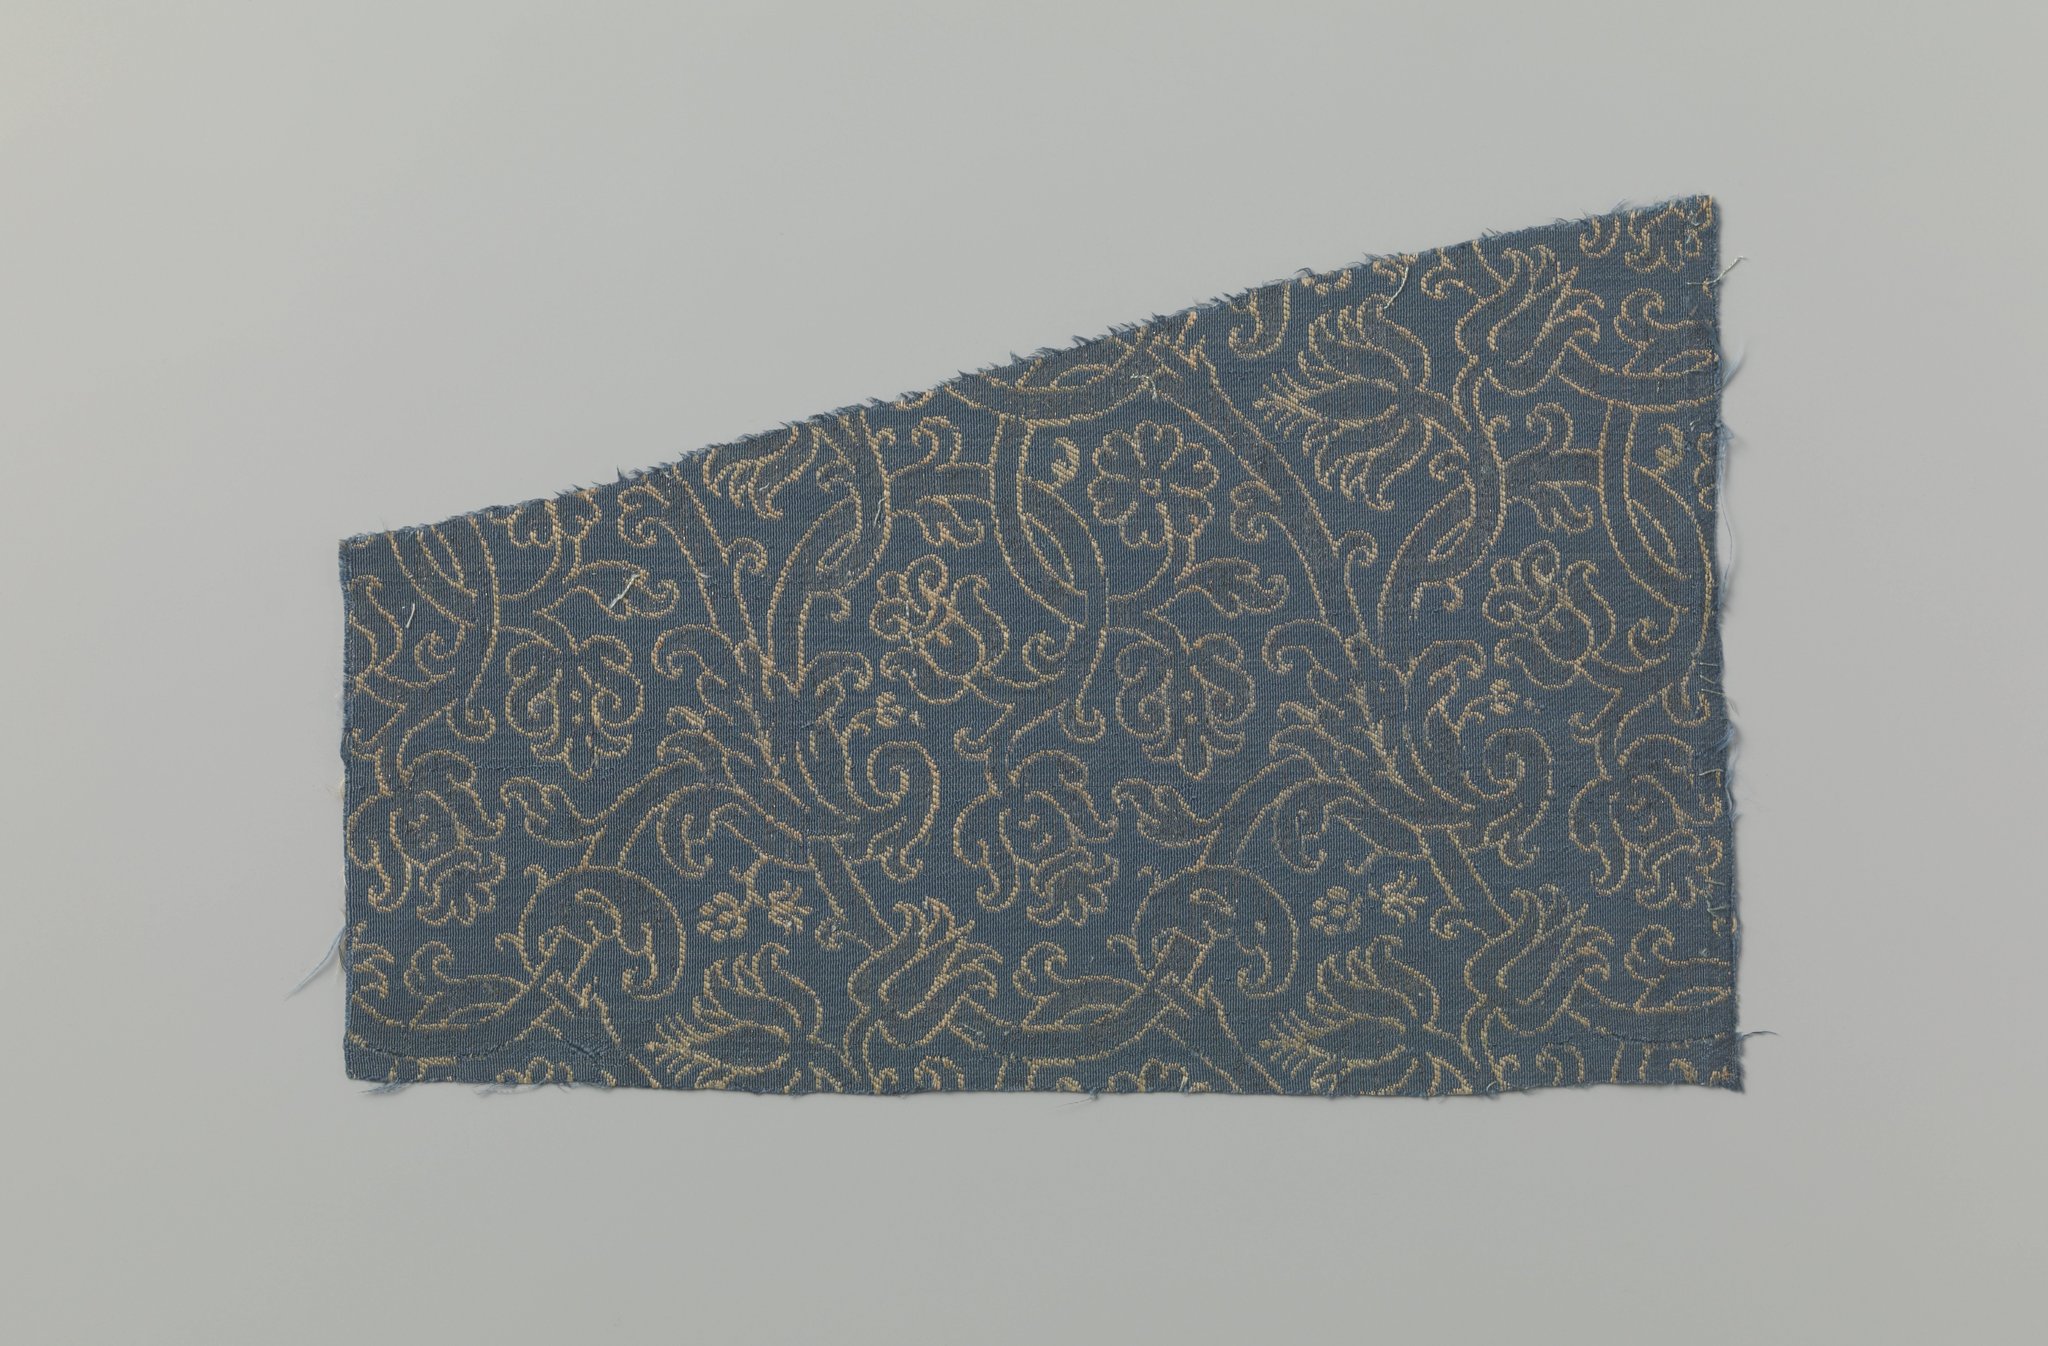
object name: fragment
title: Fragment blauwe zijden samiet met ferronneriepatroon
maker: Anonymous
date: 1500-1599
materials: silk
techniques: samite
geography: italy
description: Fragment blauwe zijde met ferronneriepatroon in zilver van asymmetrische in elkaar hakende ranken met tulp, palmet en rozet.